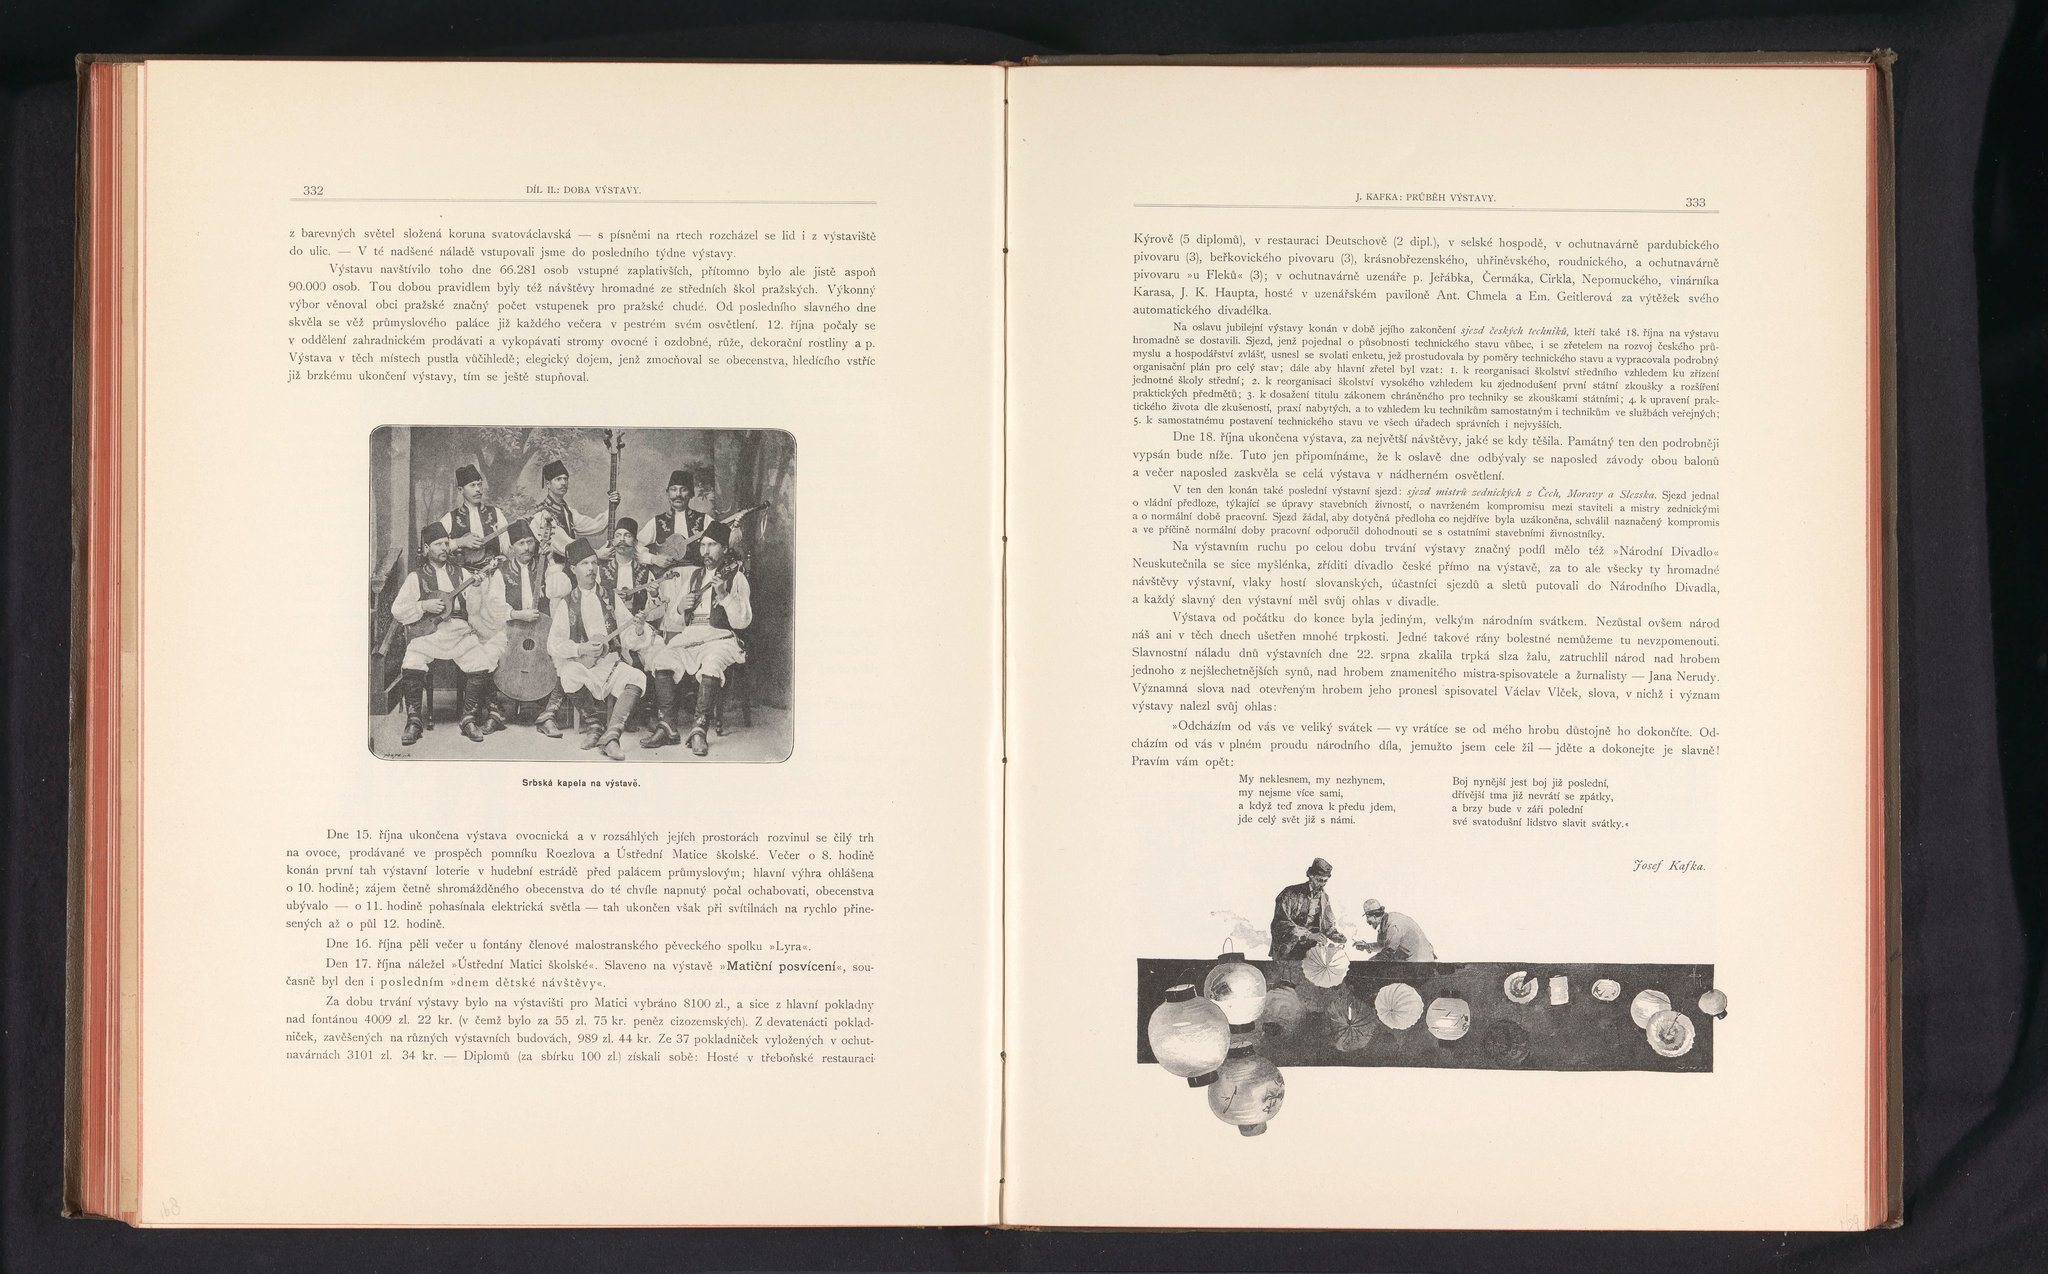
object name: page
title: Groepsportret van een Servisch muziekgezelschap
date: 1891-1893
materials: paper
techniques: autotype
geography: prague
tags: small group of musicians, chamber orchestra, jazz band, anonymous historical persons portrayed in a group, in a group-portrait